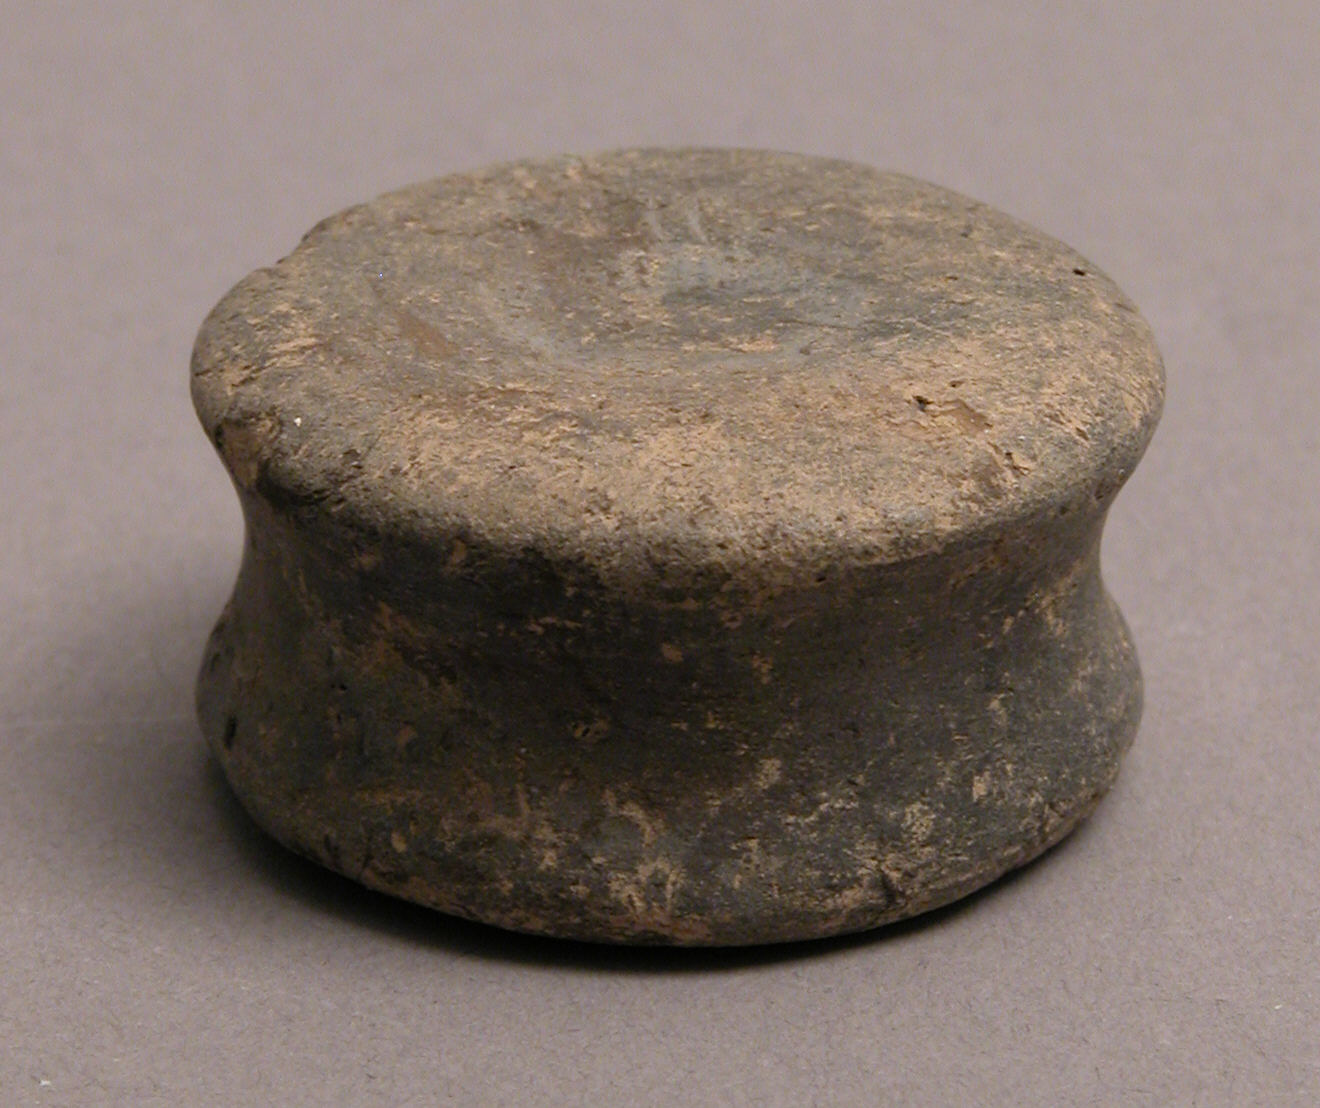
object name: game piece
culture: coptic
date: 301-700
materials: earthenware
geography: egypt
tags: games